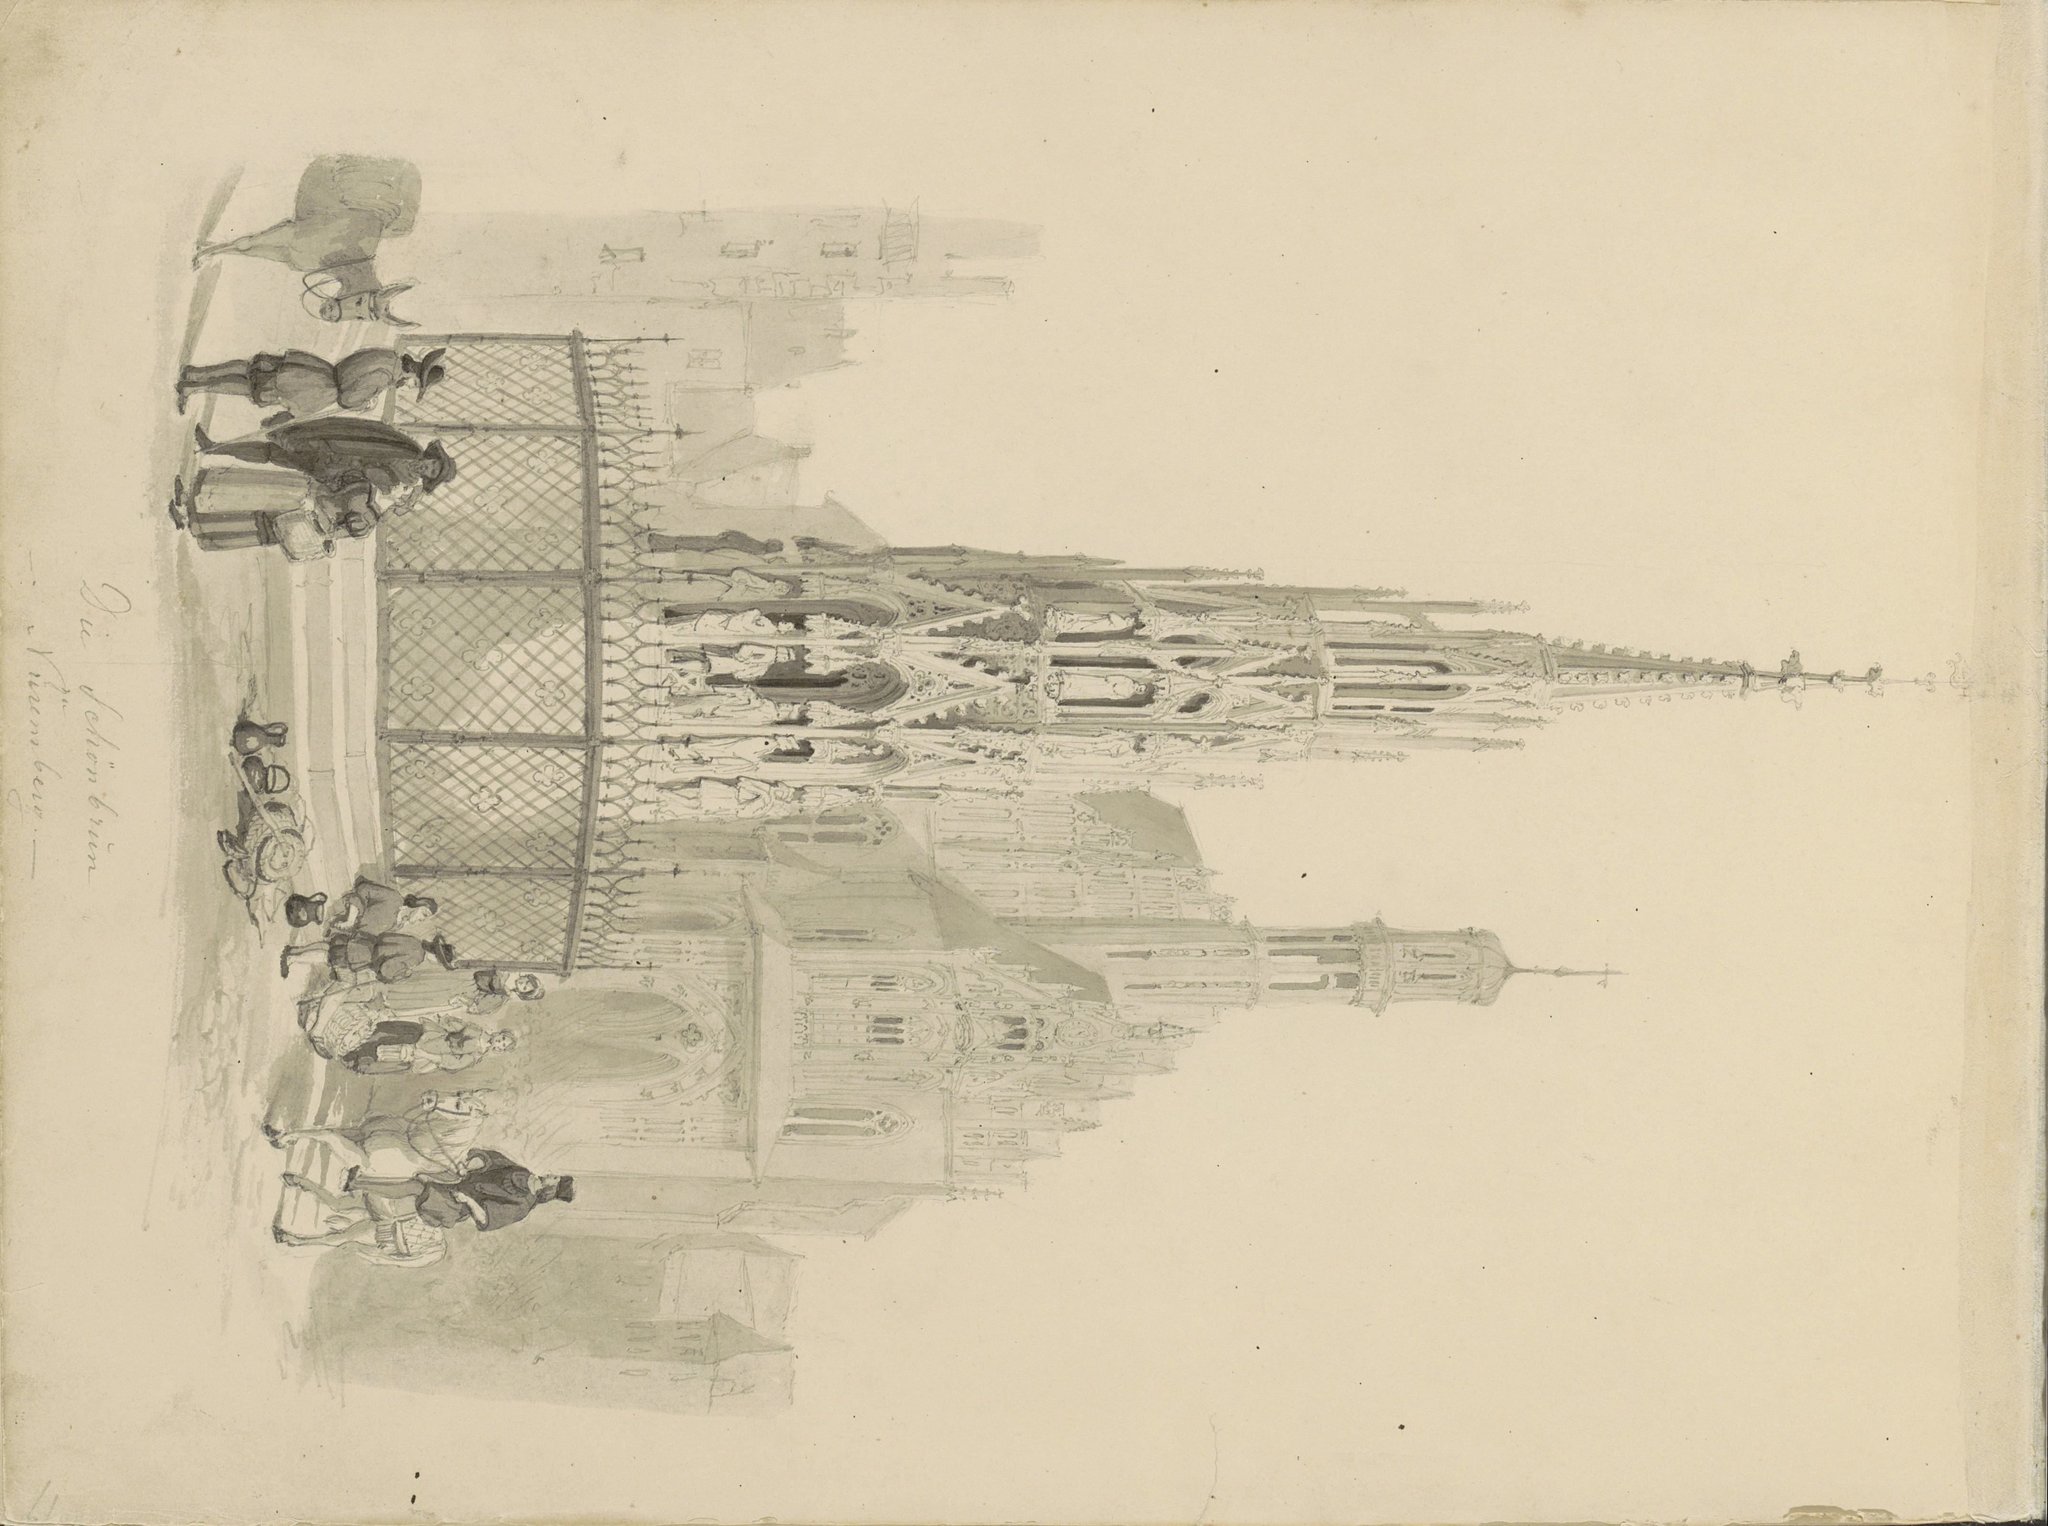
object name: sketchbook leaf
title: Schöner Brunnen te Neurenberg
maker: pierre joseph hubert cuypers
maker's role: draughtsman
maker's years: 1827-1921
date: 1850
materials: paper, pencil, watercolor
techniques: brush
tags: church (exterior), ornamental fountain, street (+ city(-scape) with figures, staffage)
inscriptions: annotation: ‘Die Schönbrün/ - Nüremberg.-’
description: Op de achtergrond de Onze-Lieve-Vrouwekerk. Op de voorgrond figuren. Blad 16 verso uit een schetsboek met 37 bladen.